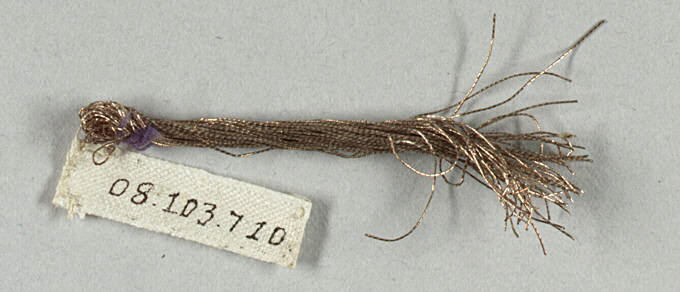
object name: thread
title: Tinsel and metal thread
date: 1601-1800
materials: metal thread